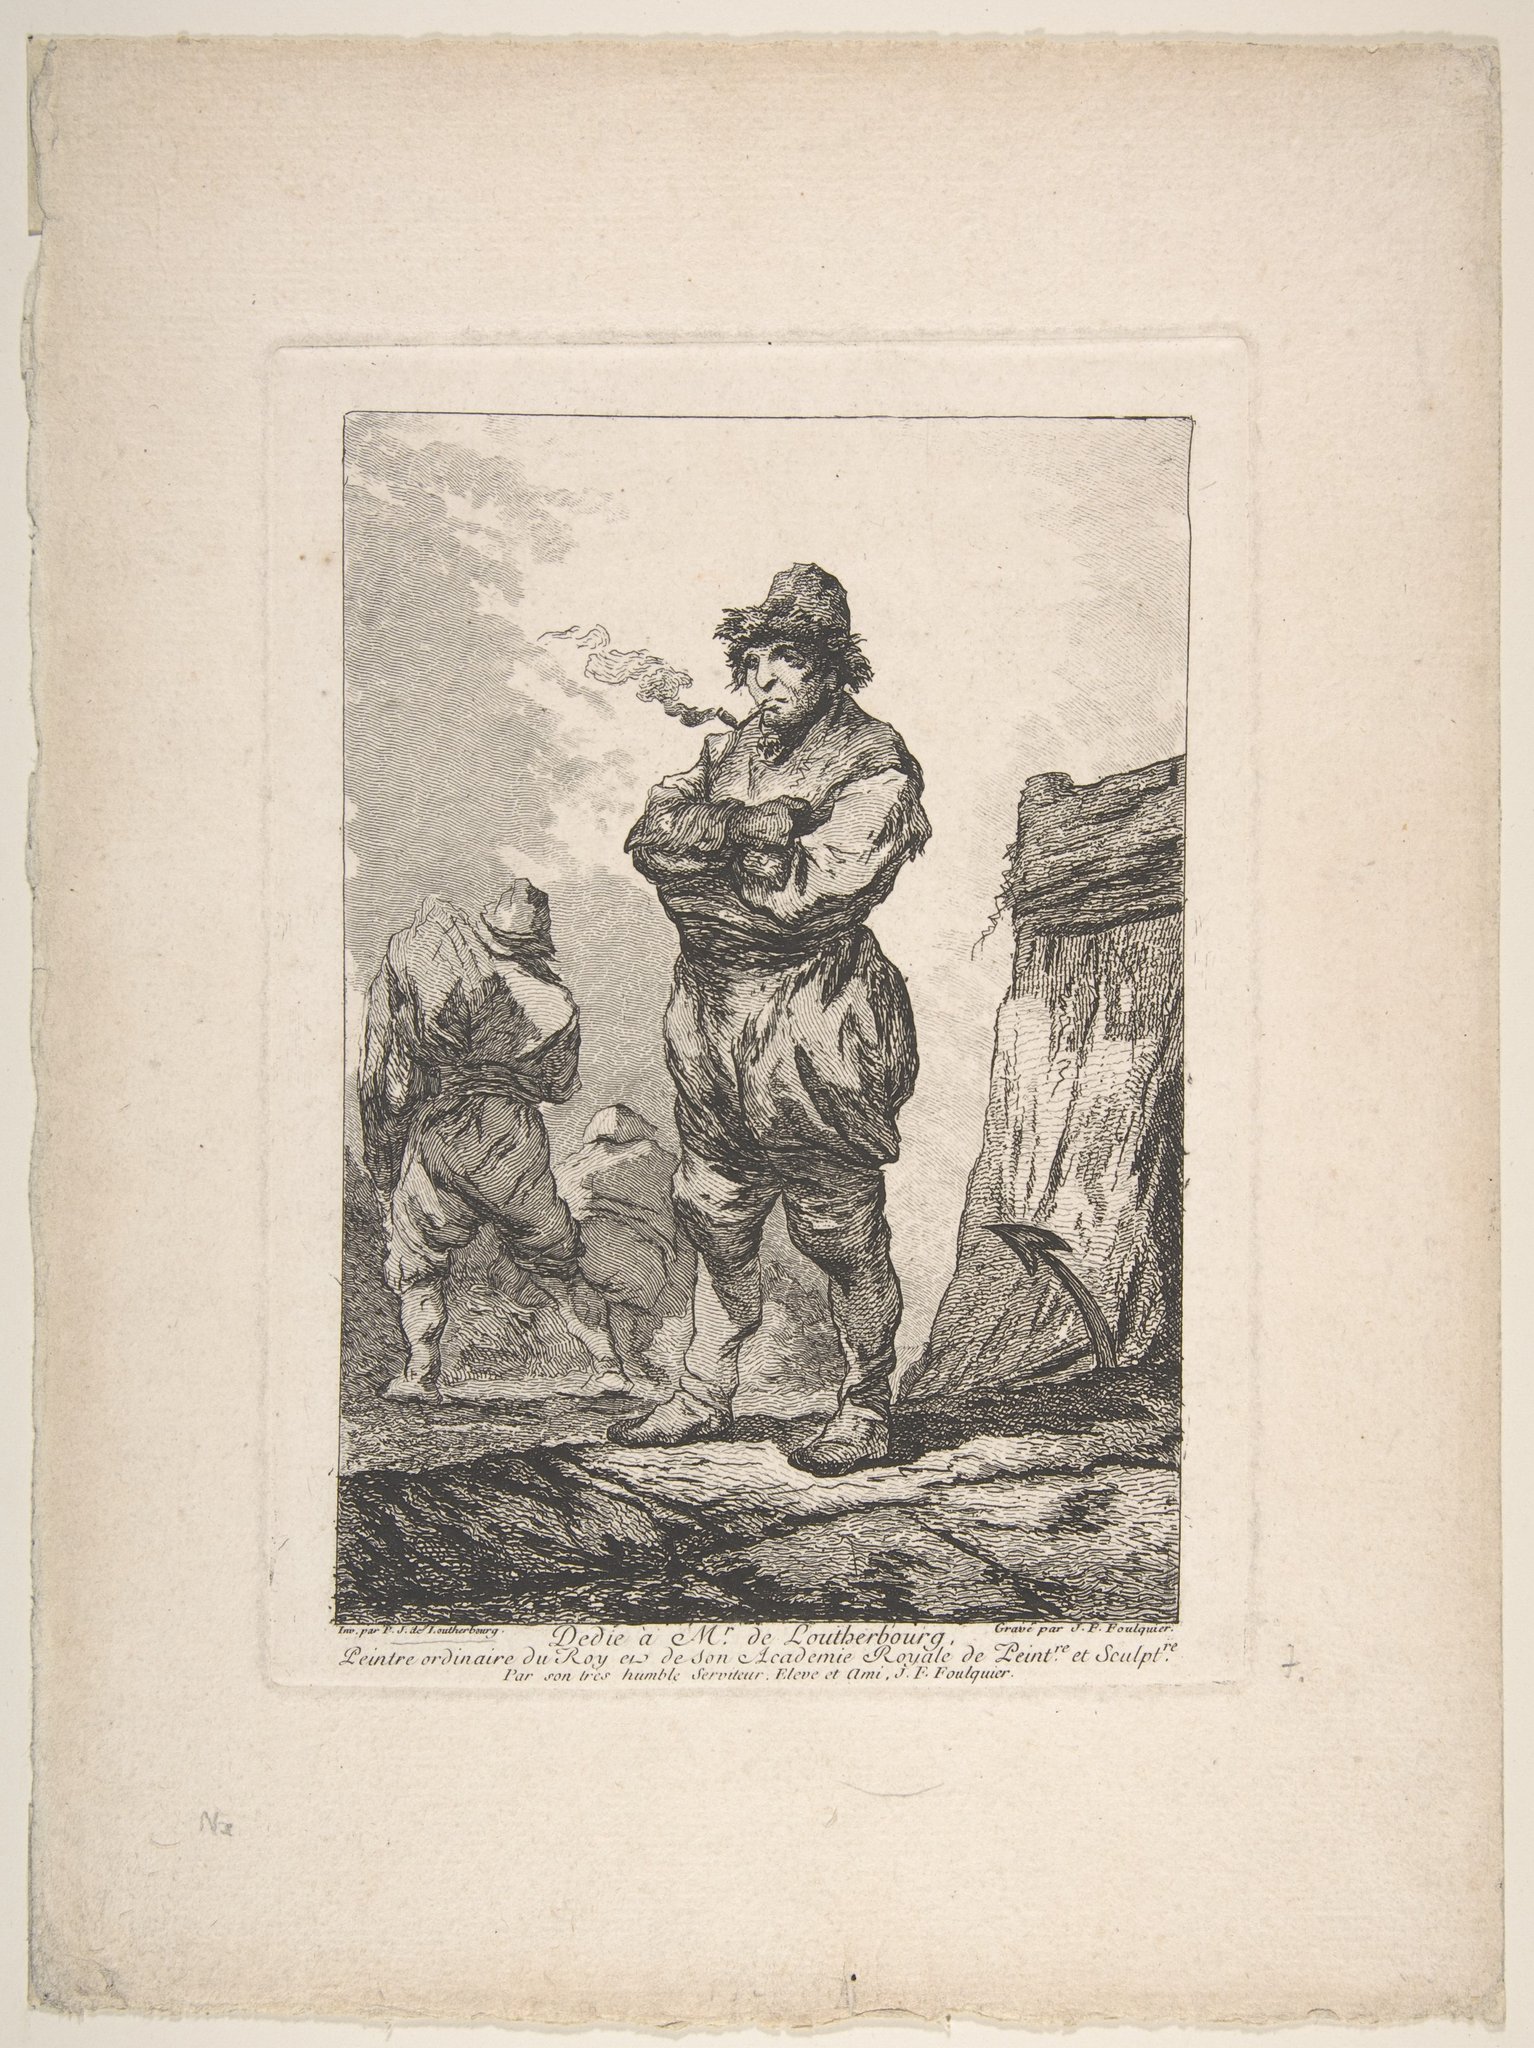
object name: print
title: A Sailor Smoking with His Arms Crossed, from "Matelots"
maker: joseph françois foulquier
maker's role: artist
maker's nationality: french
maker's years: 1744-1789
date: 1769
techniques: etching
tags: men,smoking,sailors